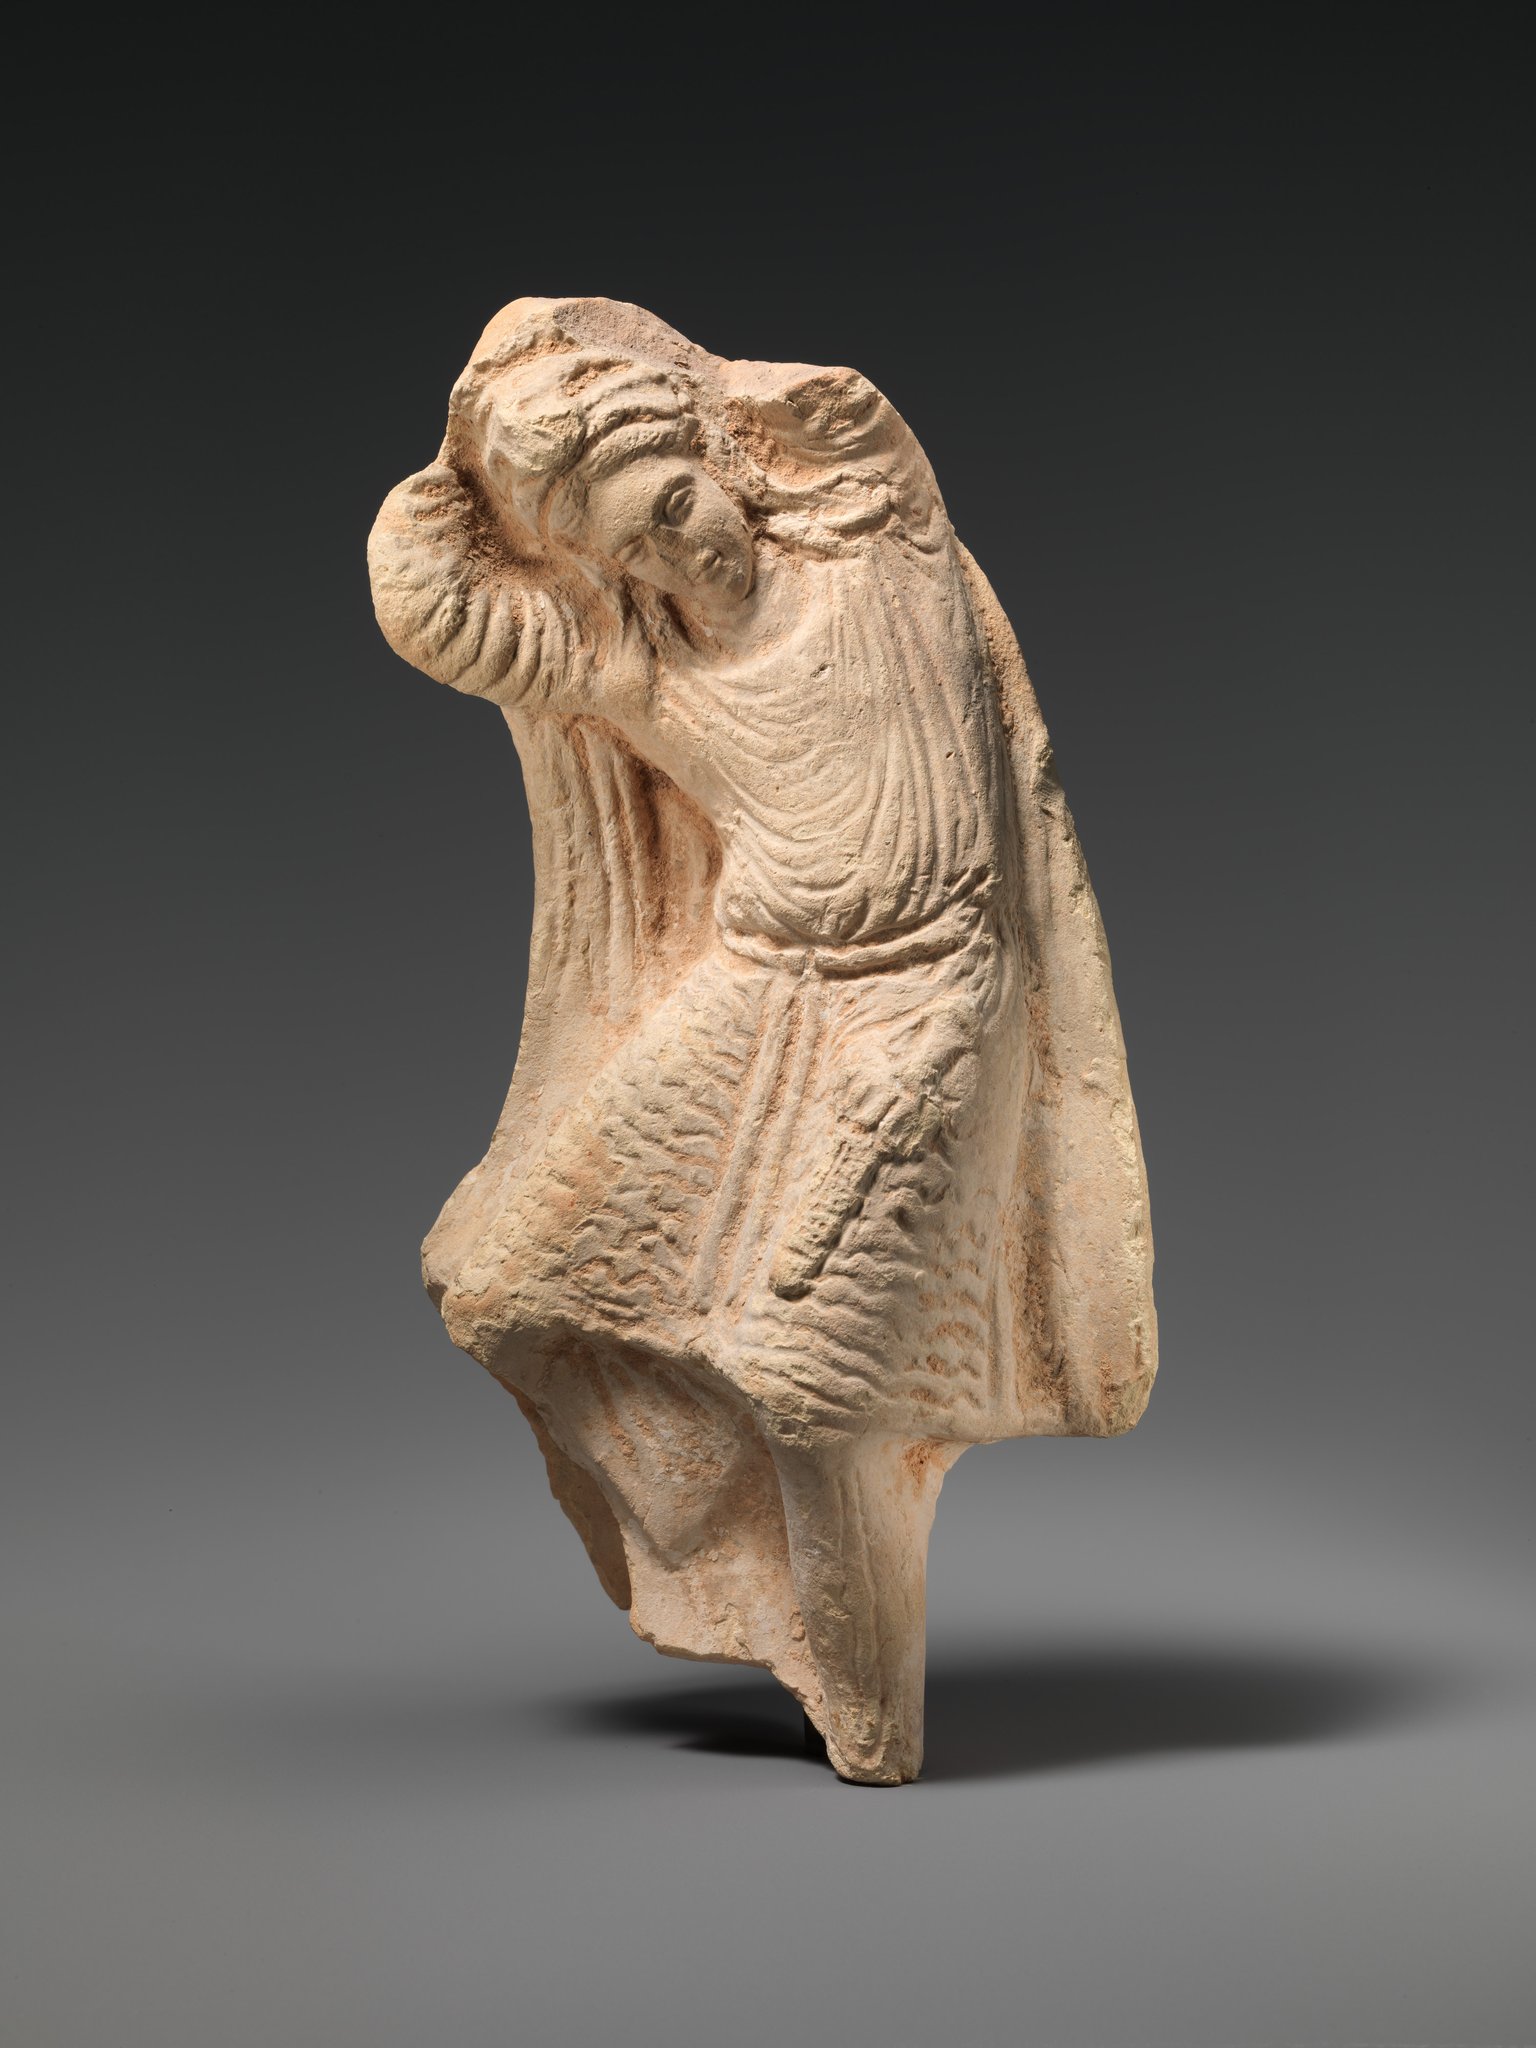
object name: statuette of a votary, phrygian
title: Terracotta statuette of a dancing youth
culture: cypriot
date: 300-201 BCE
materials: terracotta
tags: women,dancing,dancers